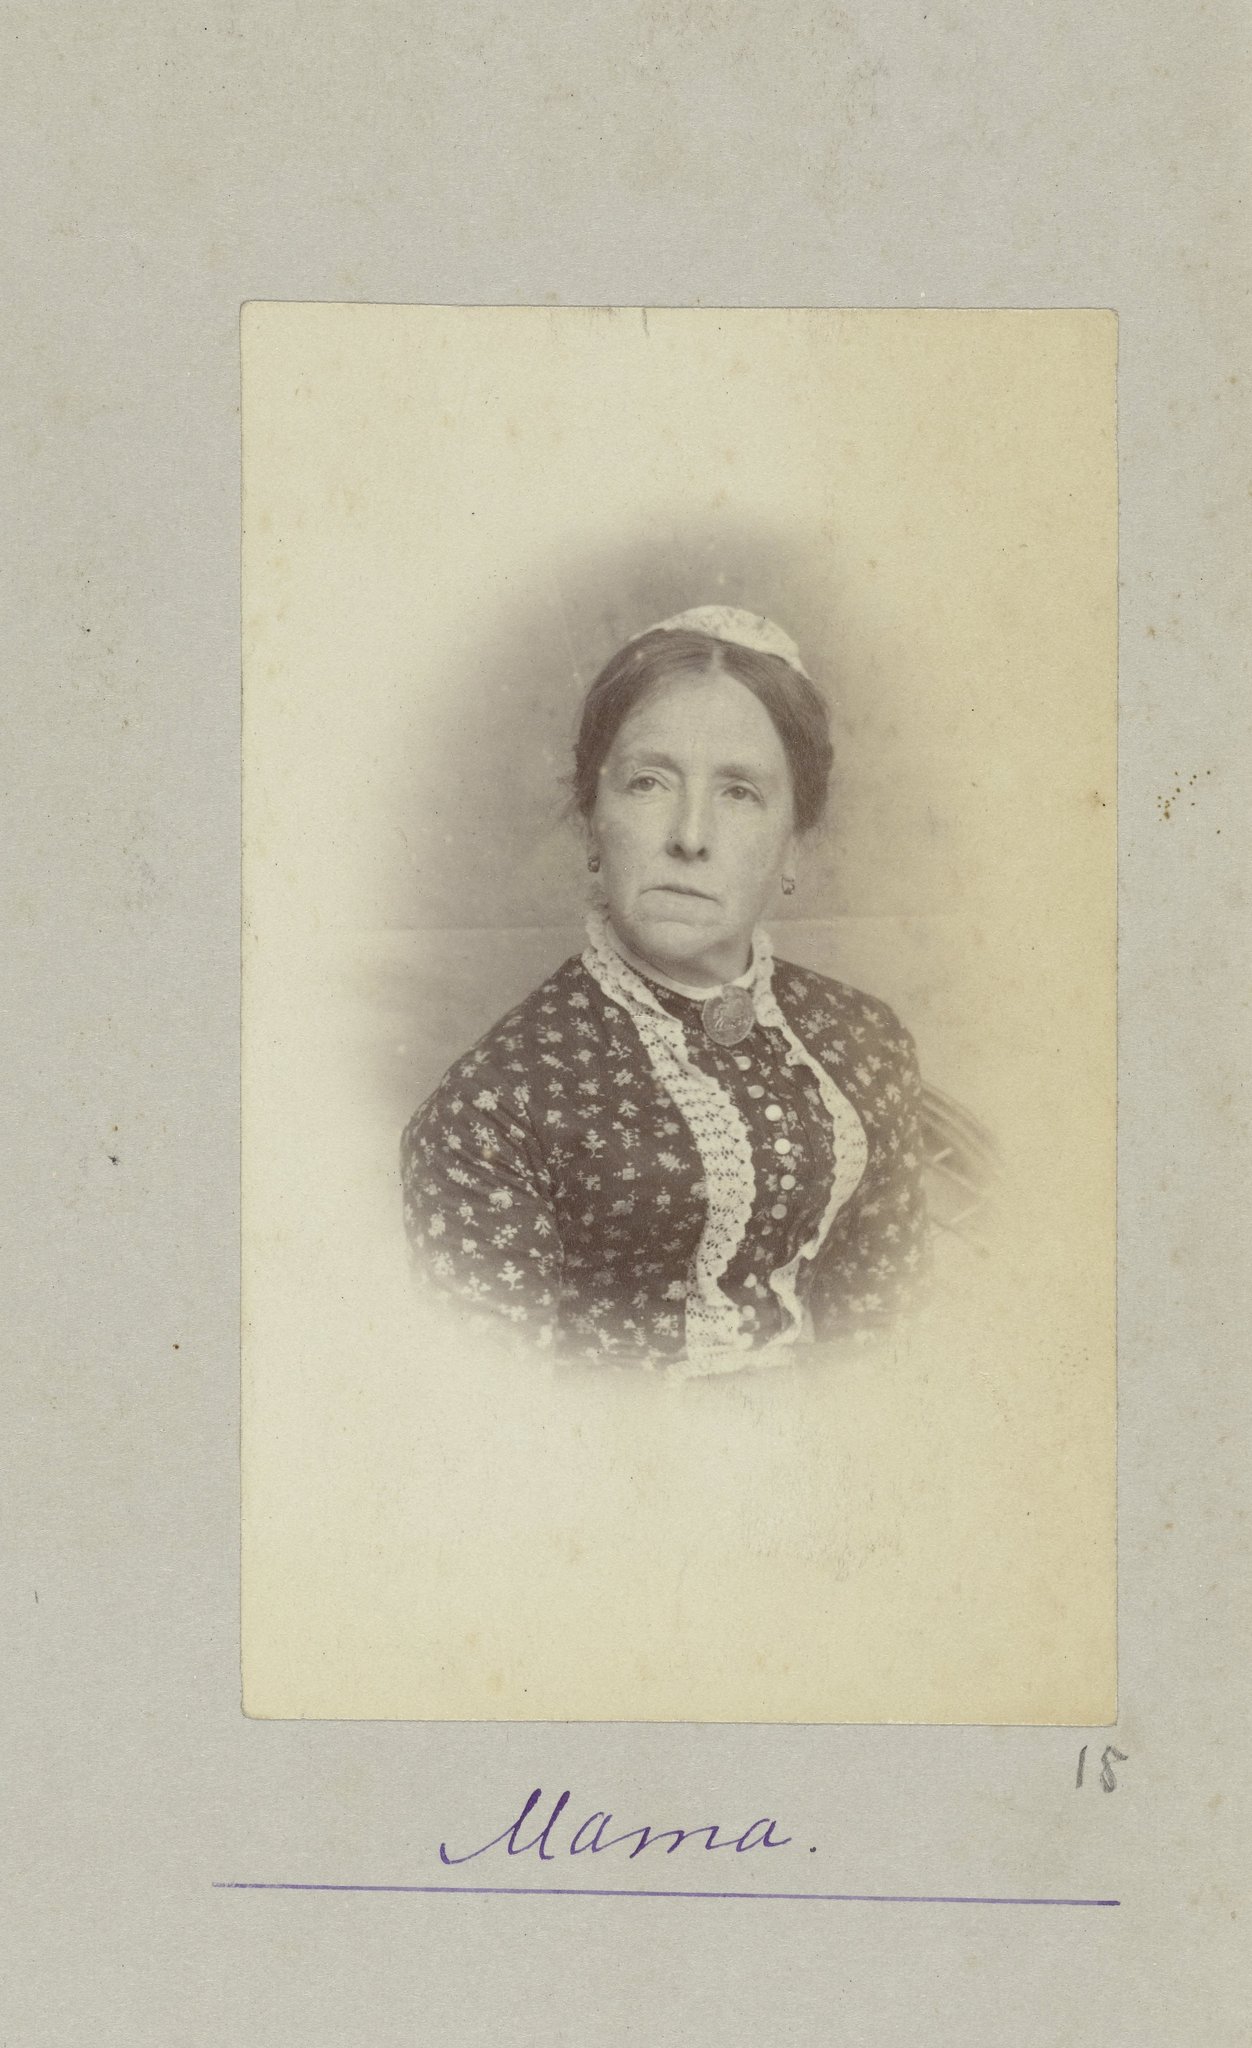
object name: photograph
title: Portret van Aletta Cornelia Anna Voombergh, getrouwd Pauw van Wieldrecht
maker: henry pauw van wieldrecht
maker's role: fotograaf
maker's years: 1863-1912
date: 1888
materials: paper, photographic support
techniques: albumen print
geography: netherlands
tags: amsterdam